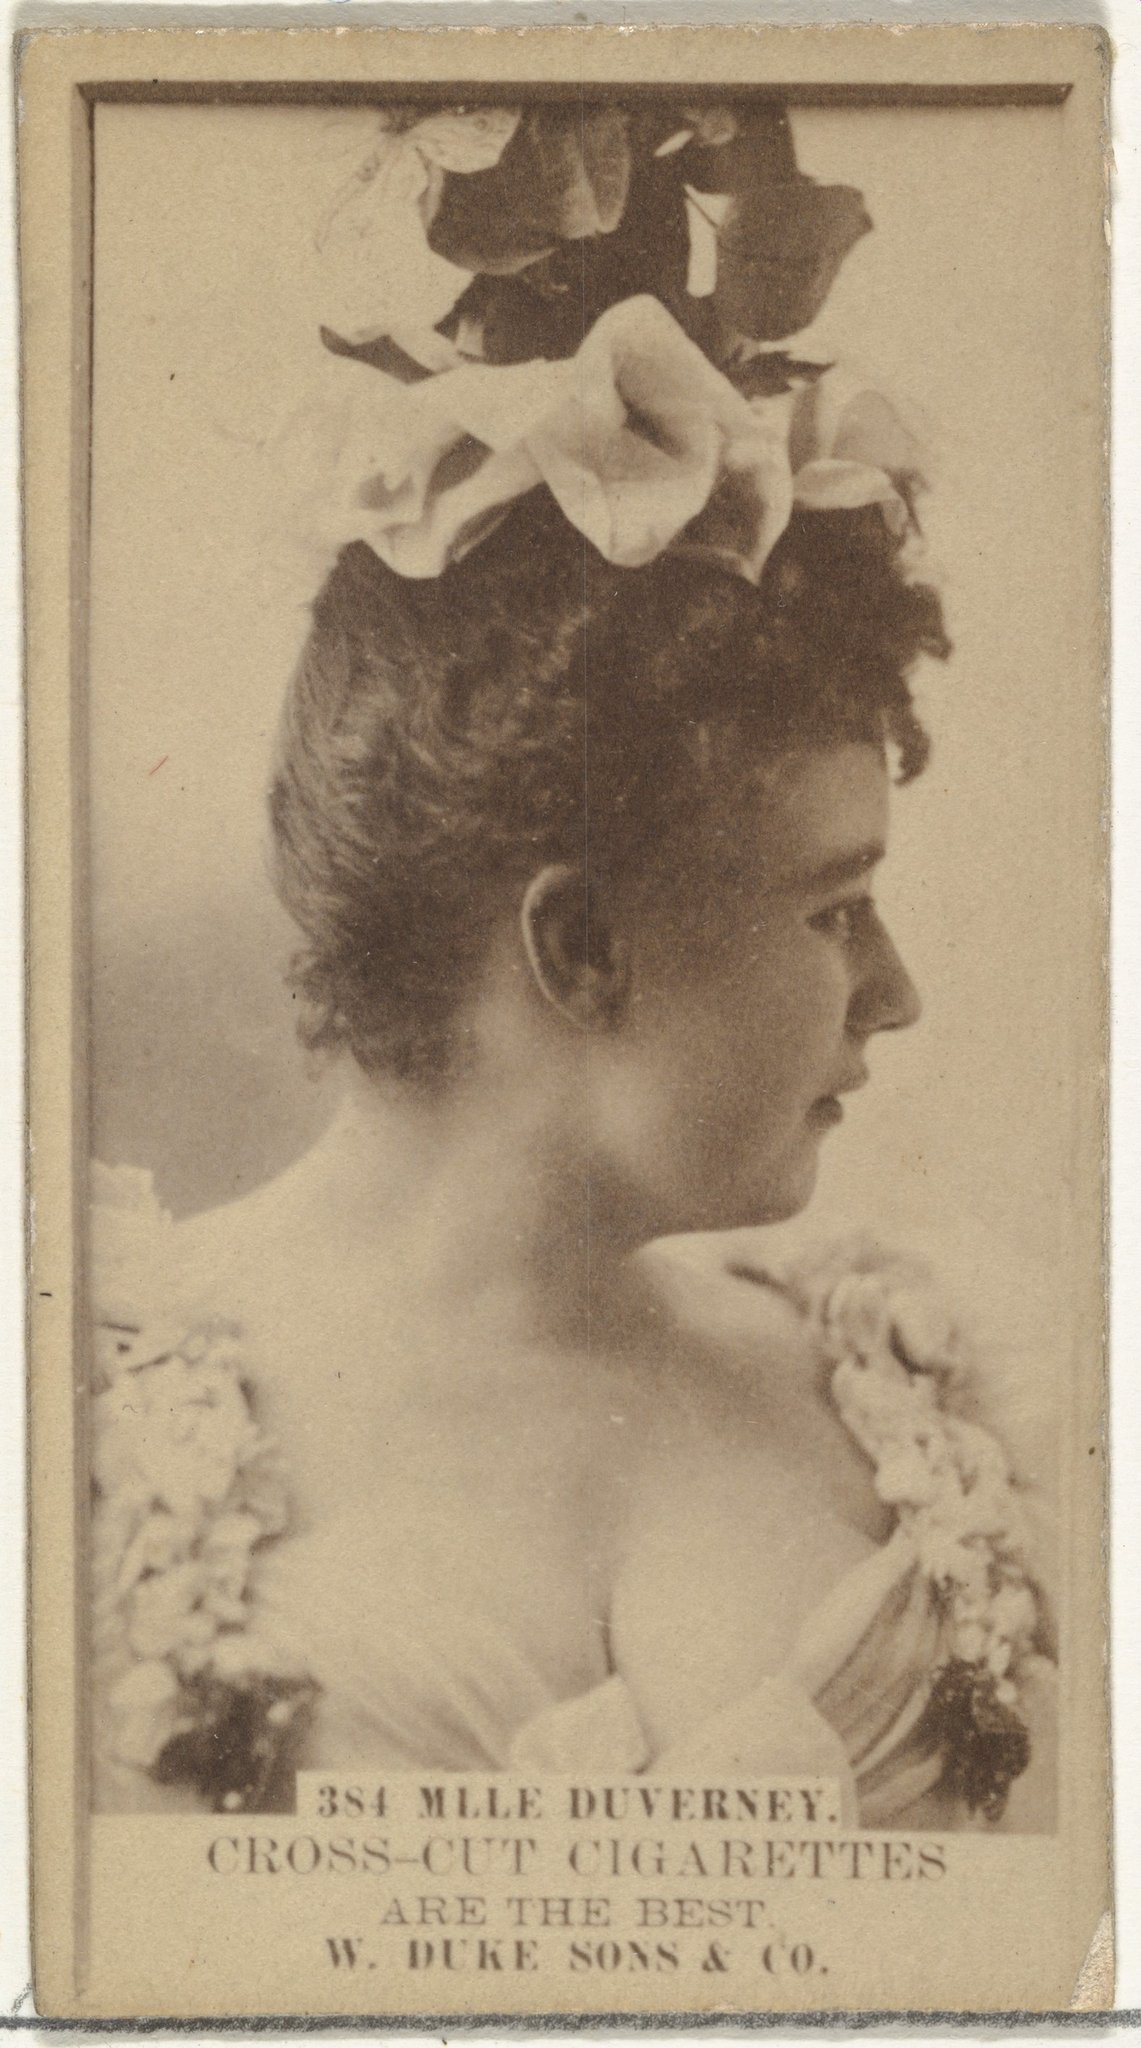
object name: photograph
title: Card Number 384, Mlle. Duverney, from the Actors and Actresses series (N145-3) issued by Duke Sons & Co. to promote Cross Cut Cigarettes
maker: w. duke, sons & co.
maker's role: publisher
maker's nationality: american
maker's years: 1870-1920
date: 1880-1889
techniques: albumen silver print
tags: women,actresses